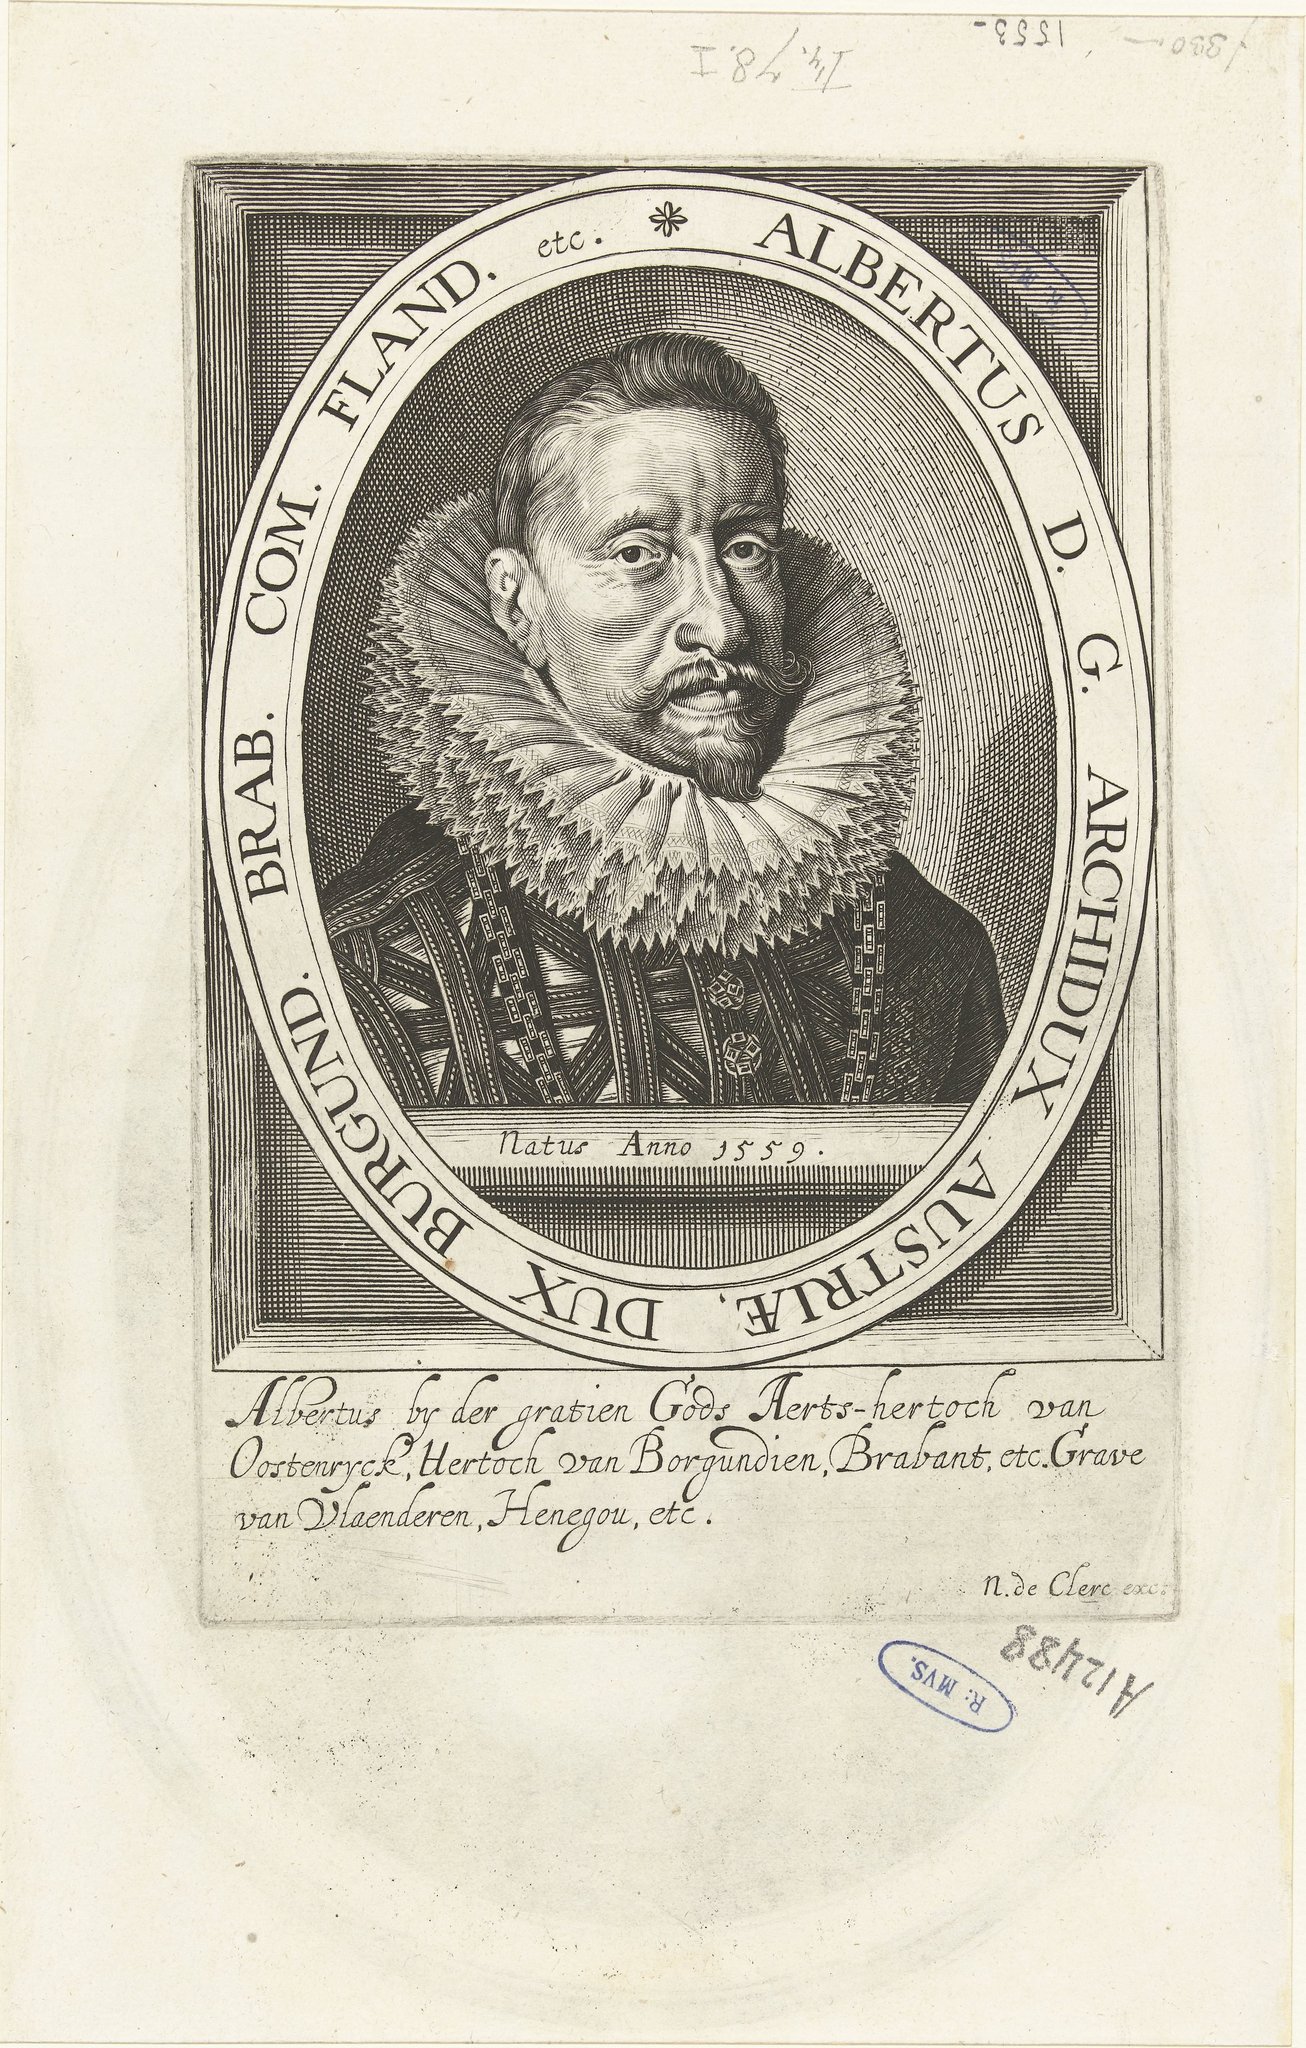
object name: print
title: Portret van Albrecht, aartshertog van Oostenrijk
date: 1619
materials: paper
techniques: engraving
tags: albrecht aartshertog van oostenrijk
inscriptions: collector's mark: Lugt 2228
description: Portret van Albrecht, aartshertog van Oostenrijk, borststuk met kanten kraag in ovale omlijsting met Latijns opschrift, in ondermarge Nederlands opschrift in drie regels.